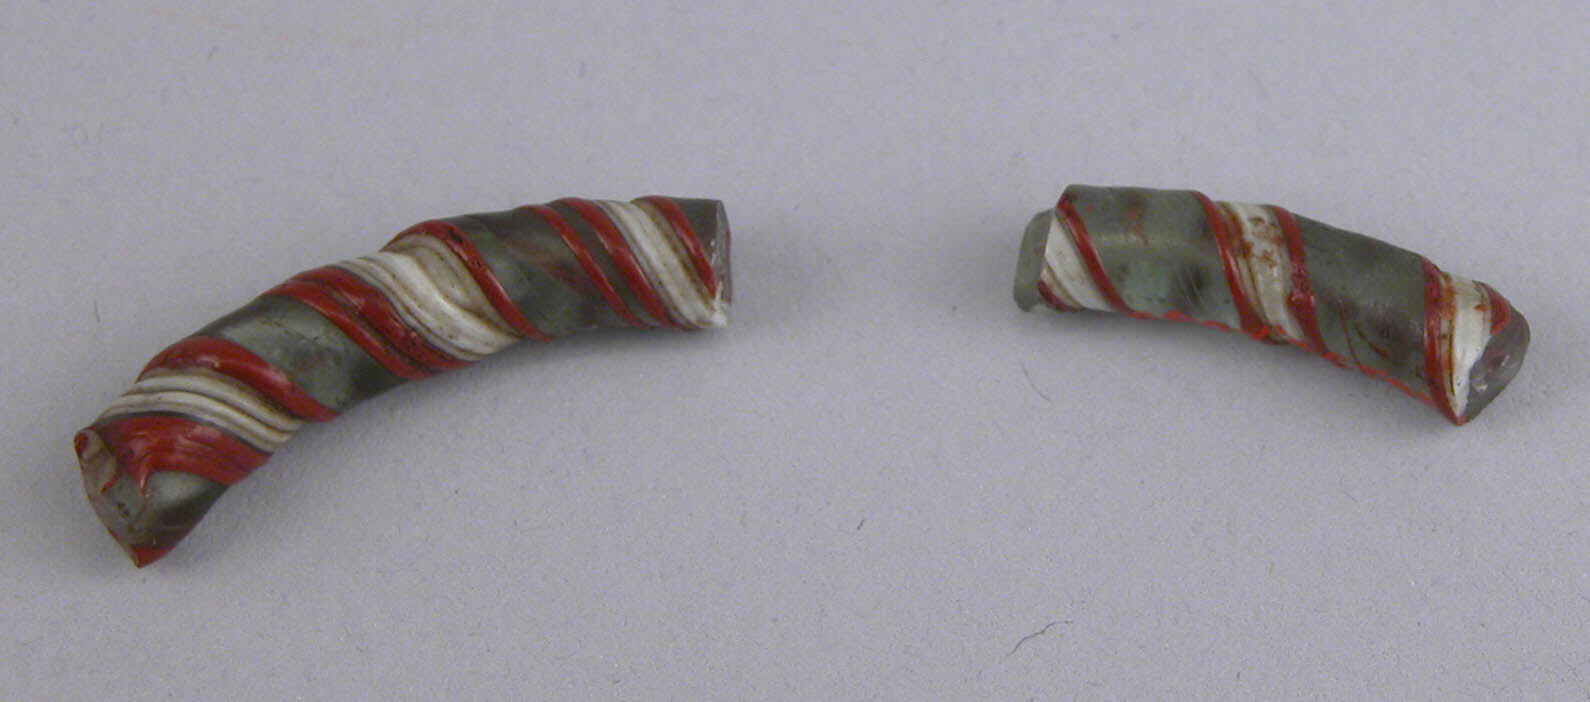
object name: bracelet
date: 1301-1500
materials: glass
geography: egypt or syria